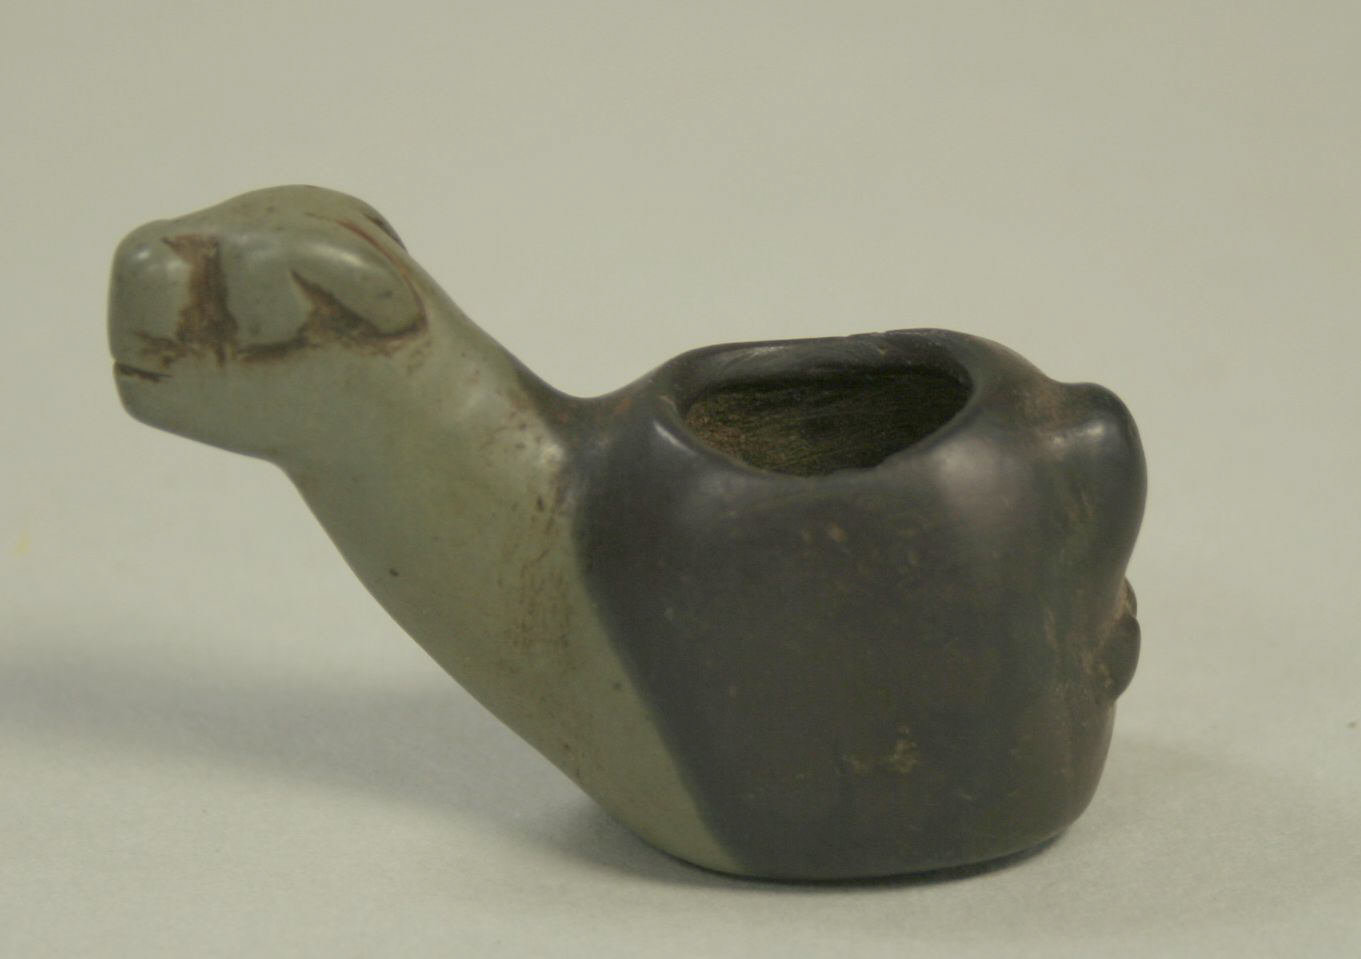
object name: container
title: Votive Container (Canopa)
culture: inca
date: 1401-1600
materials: stone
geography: peru